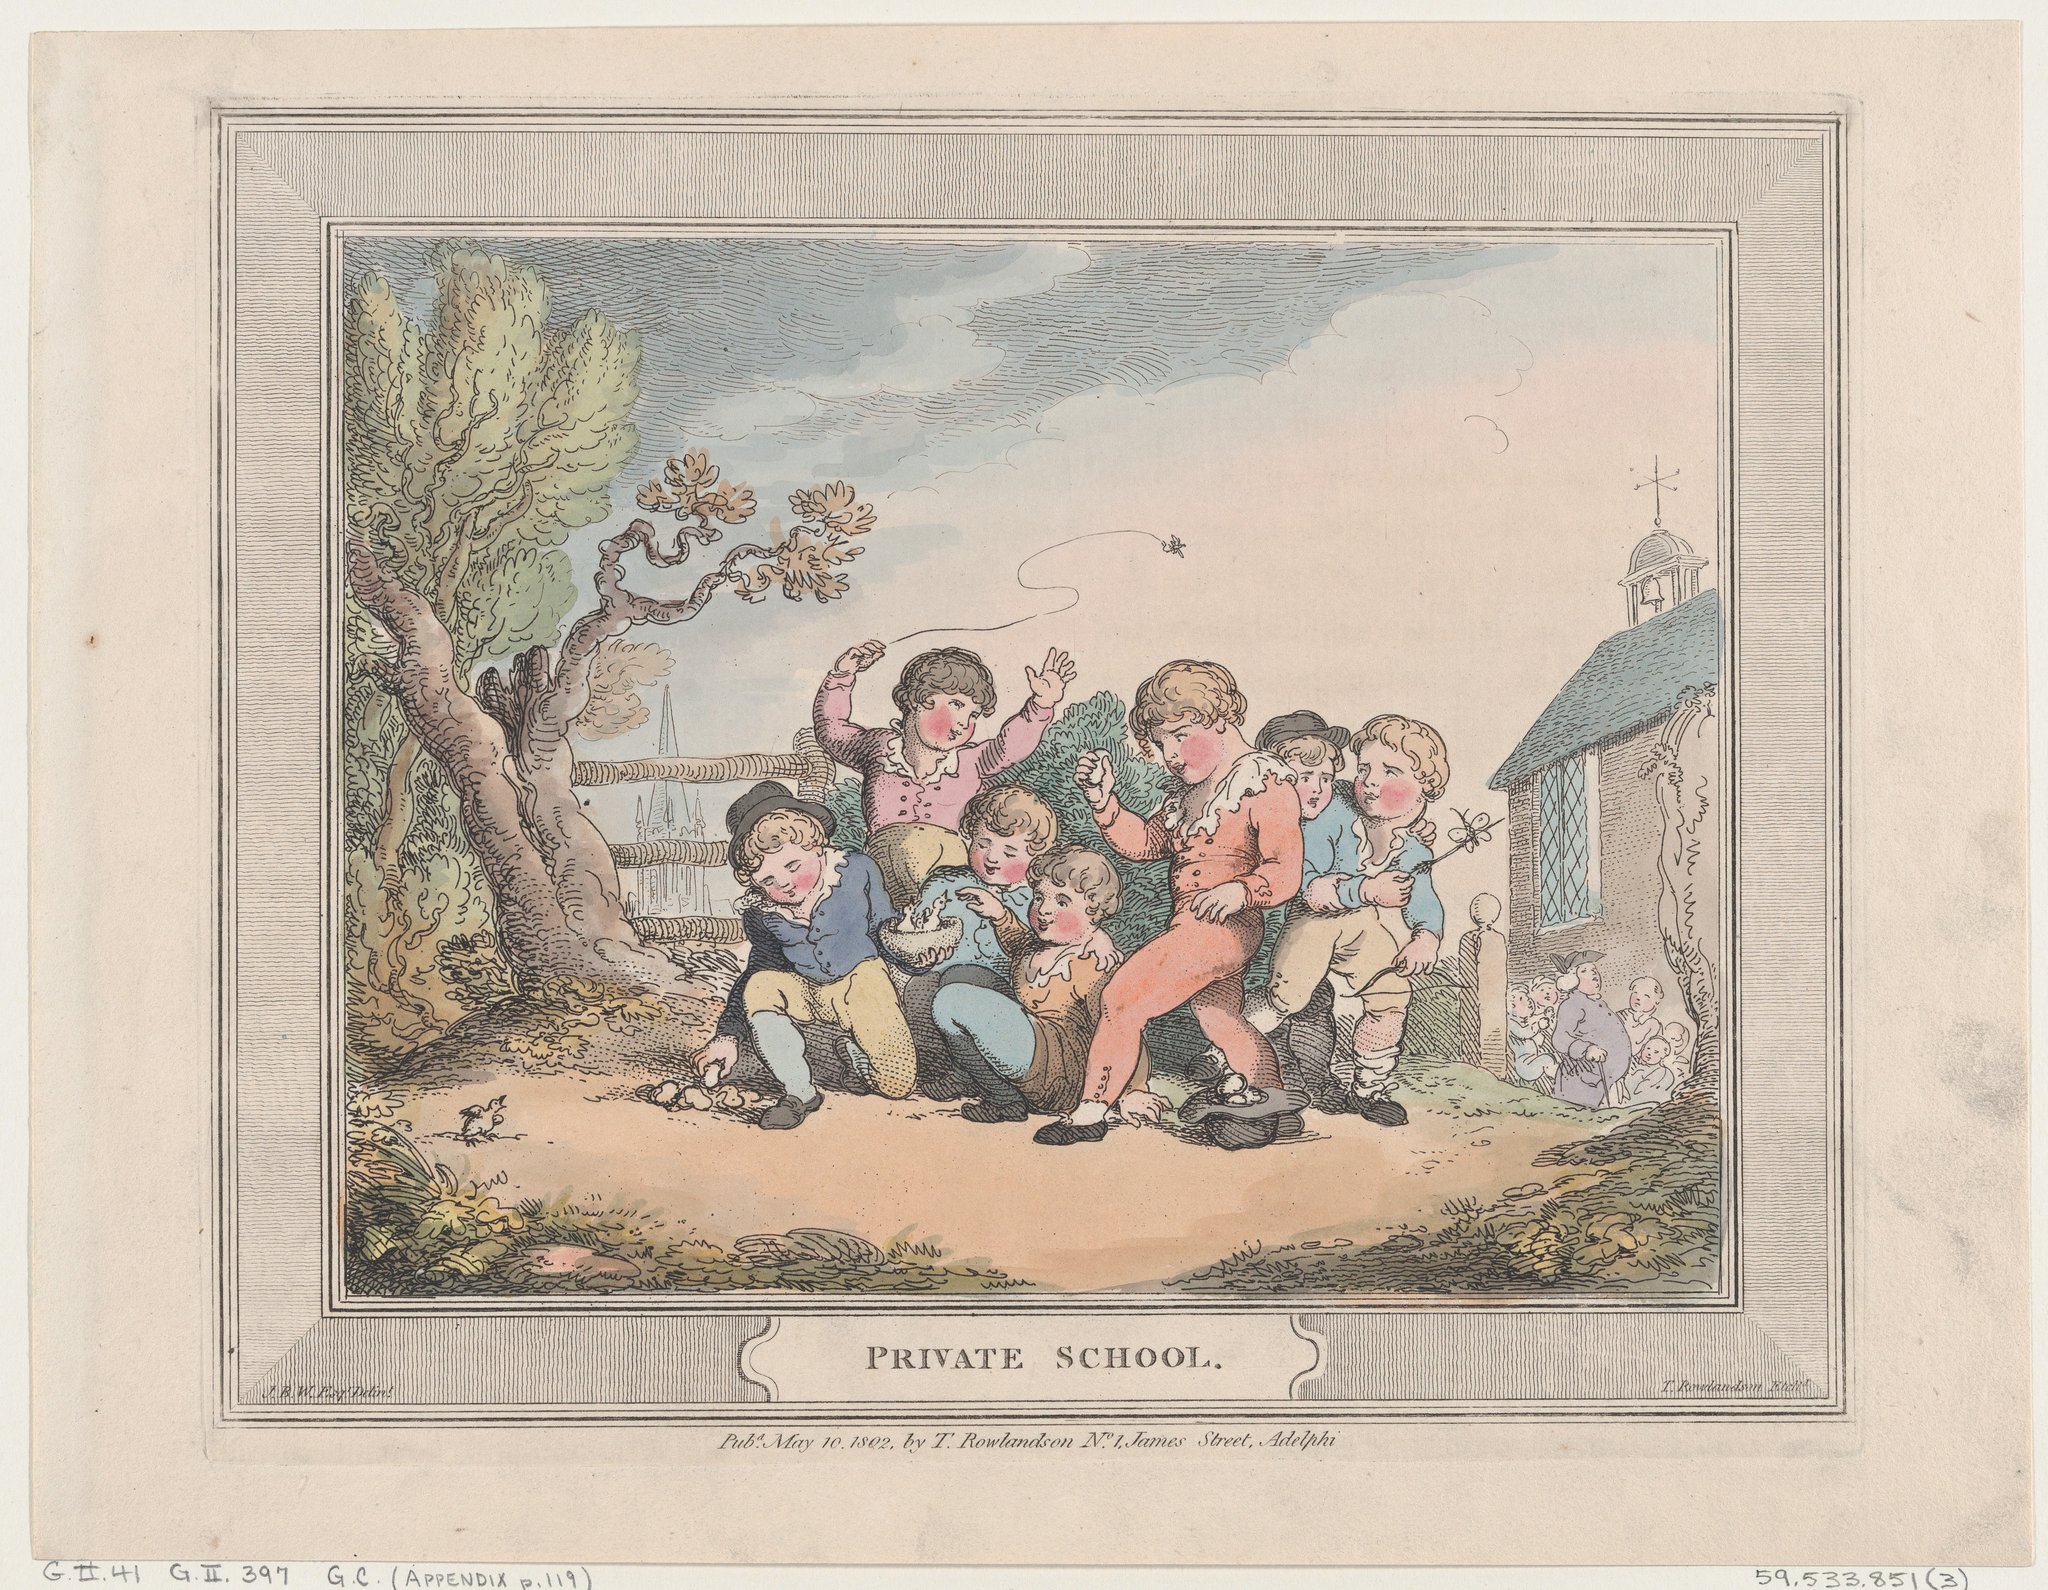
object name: print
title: Private School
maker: thomas rowlandson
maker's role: artist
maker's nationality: british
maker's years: 1757-1827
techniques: etching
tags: satire,schools,boys,playing,students